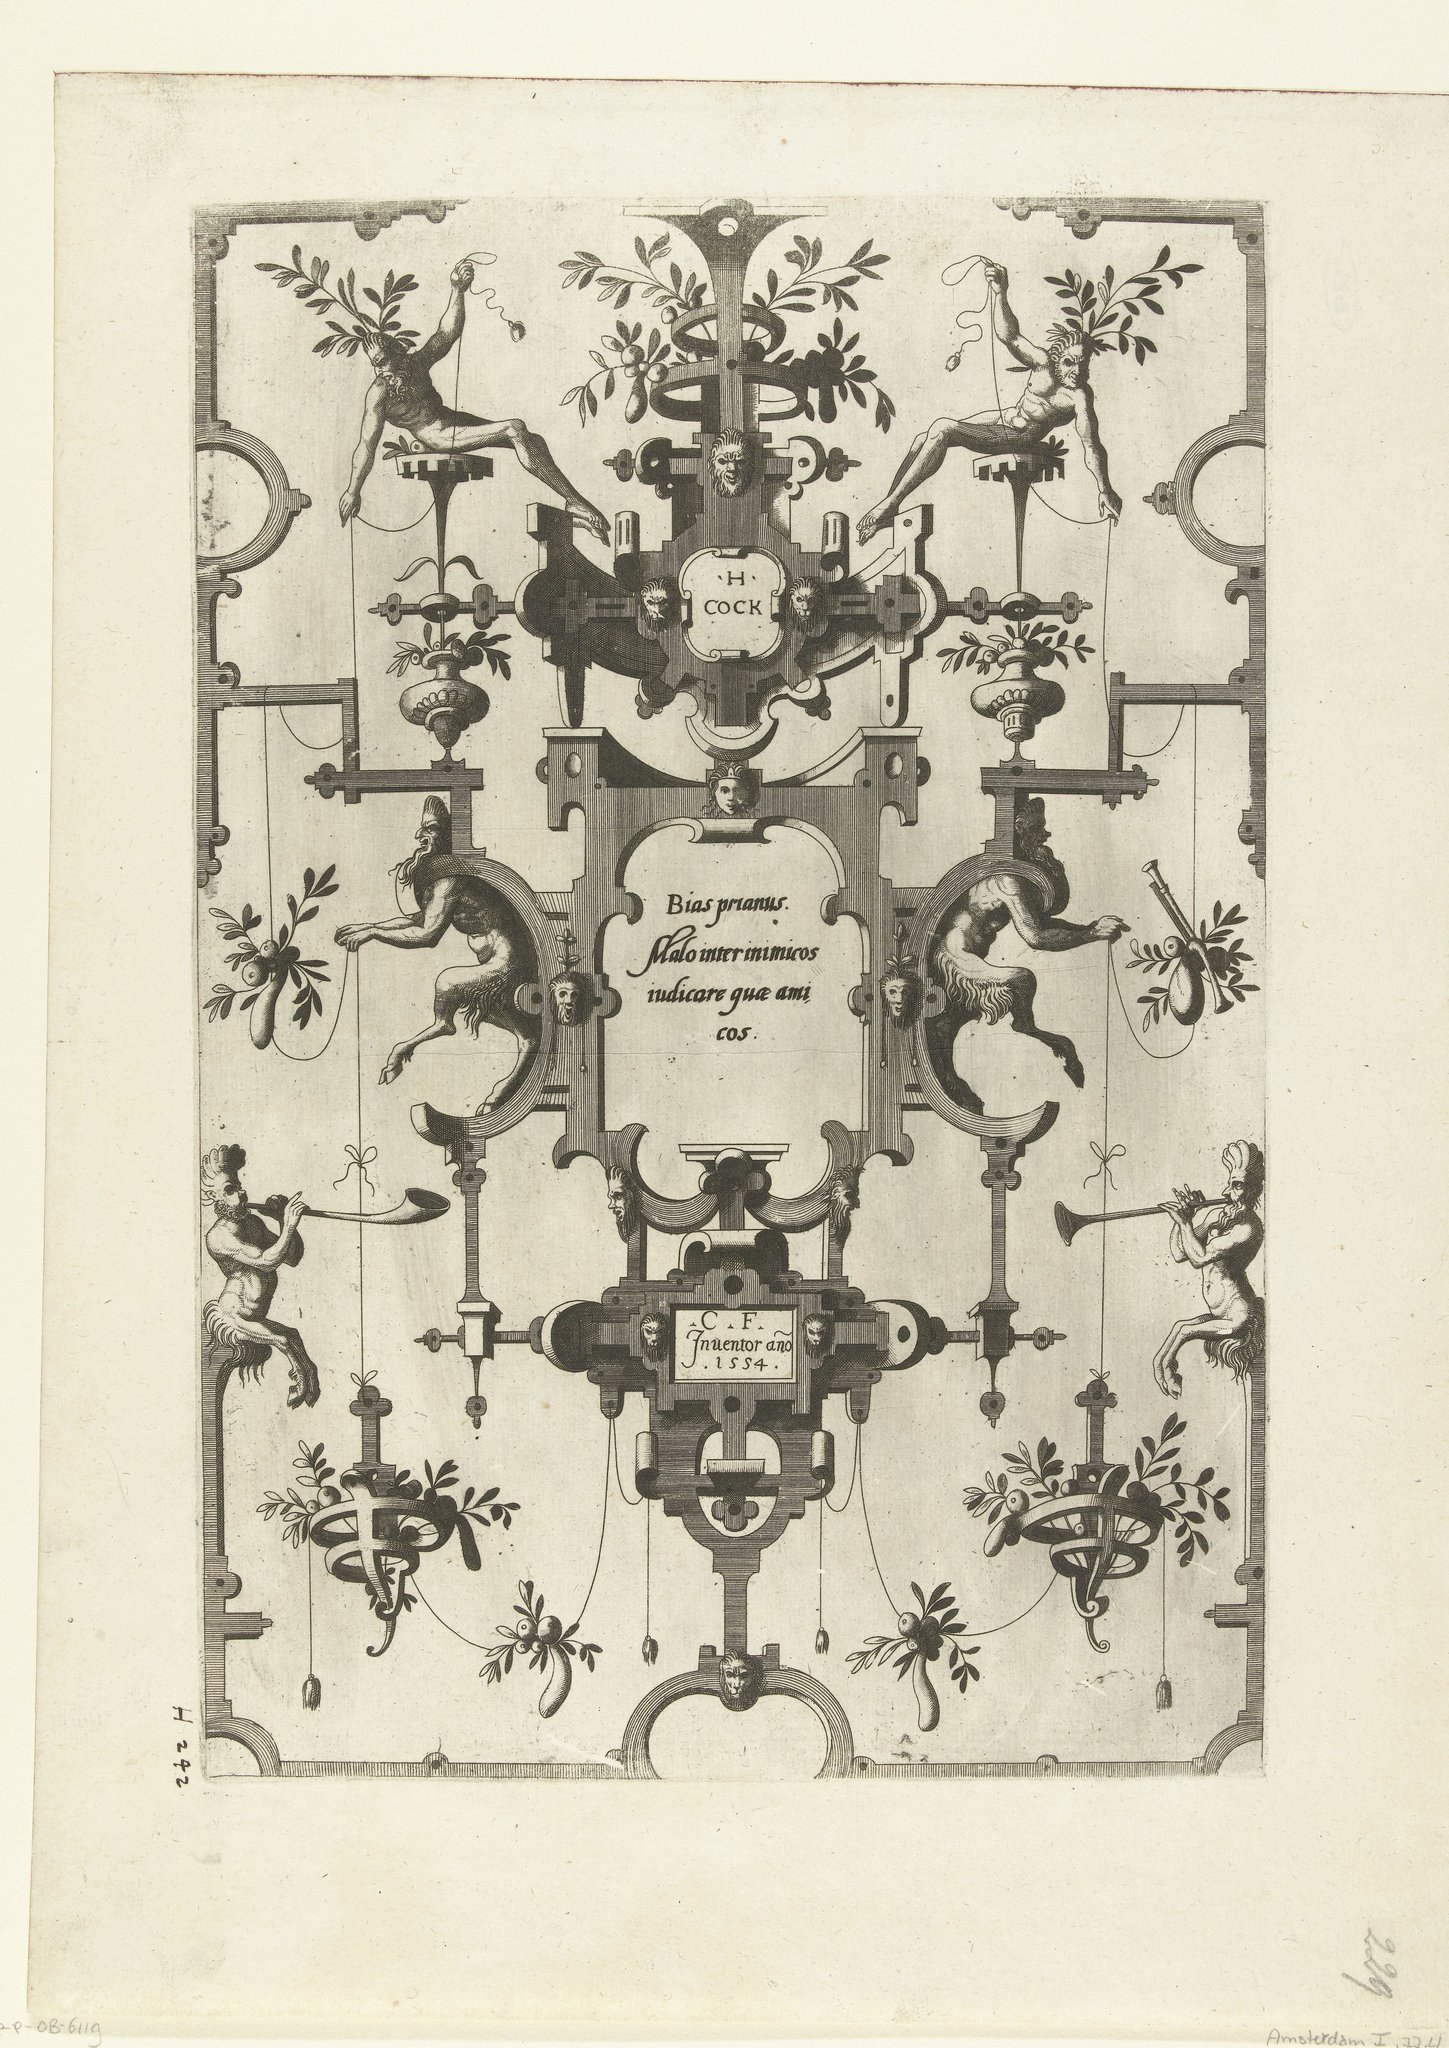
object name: ornament print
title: Cartouche met tekst van Bias tussen twee saters in rolwerk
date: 1558-1630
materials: paper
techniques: etching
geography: netherlands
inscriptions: number: ‘H. 242’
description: Linksonder en rechtsonder zit op het rolwerk een sater die op een bazuin blaast. Hoort bij serie van 6 bladen.